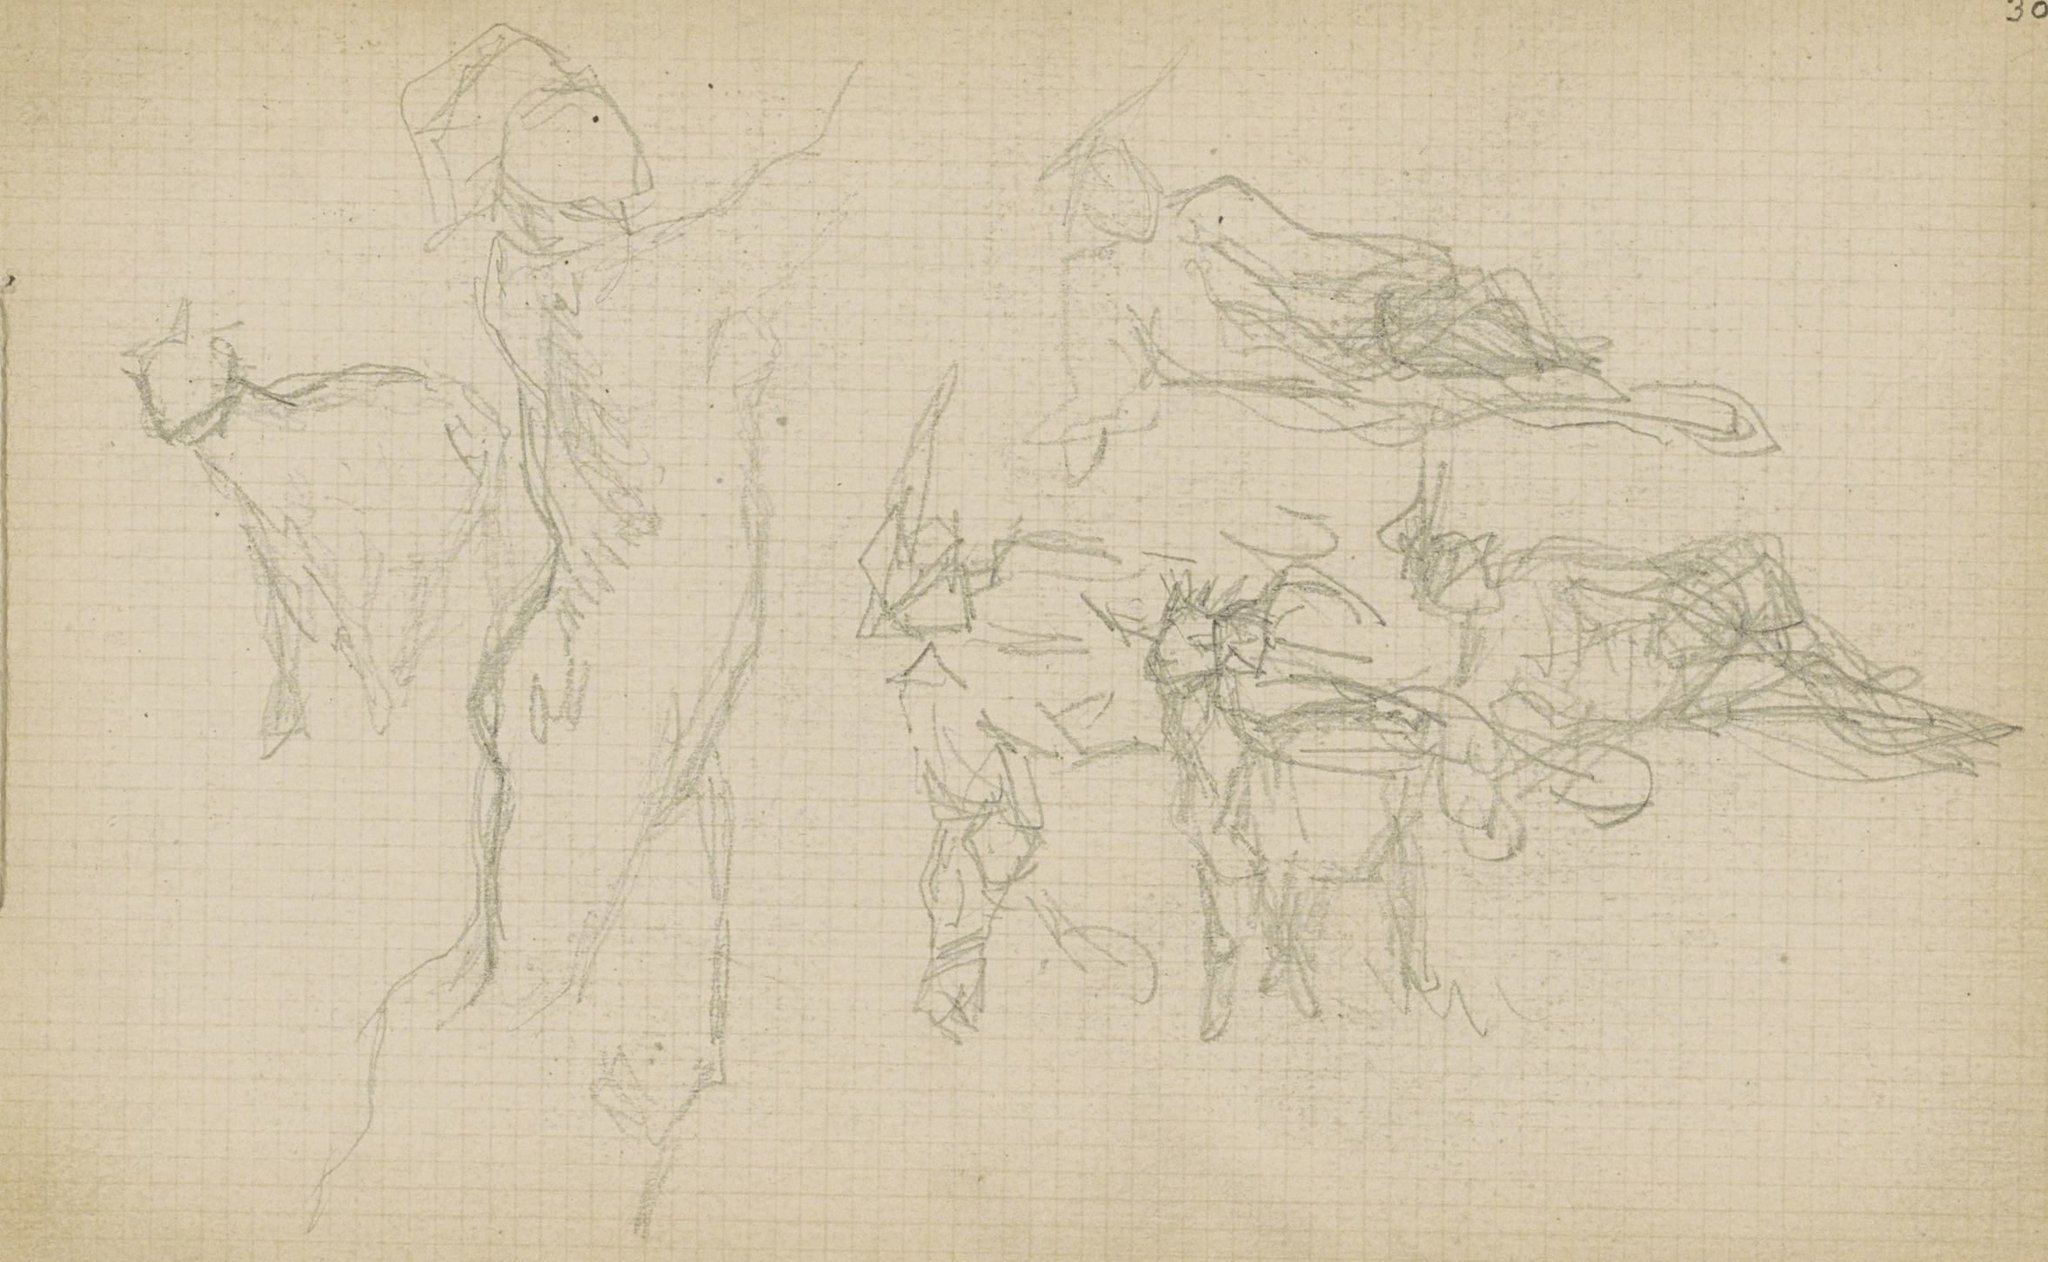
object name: sketchbook leaf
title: Geiten, een boomstam en een liggende figuur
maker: matthijs maris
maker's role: draughtsman, painter, print maker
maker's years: 1839-1917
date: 1849-1917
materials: pencil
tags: lying figure, goat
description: Blad 30 recto uit een schetsboek met 35 bladen.